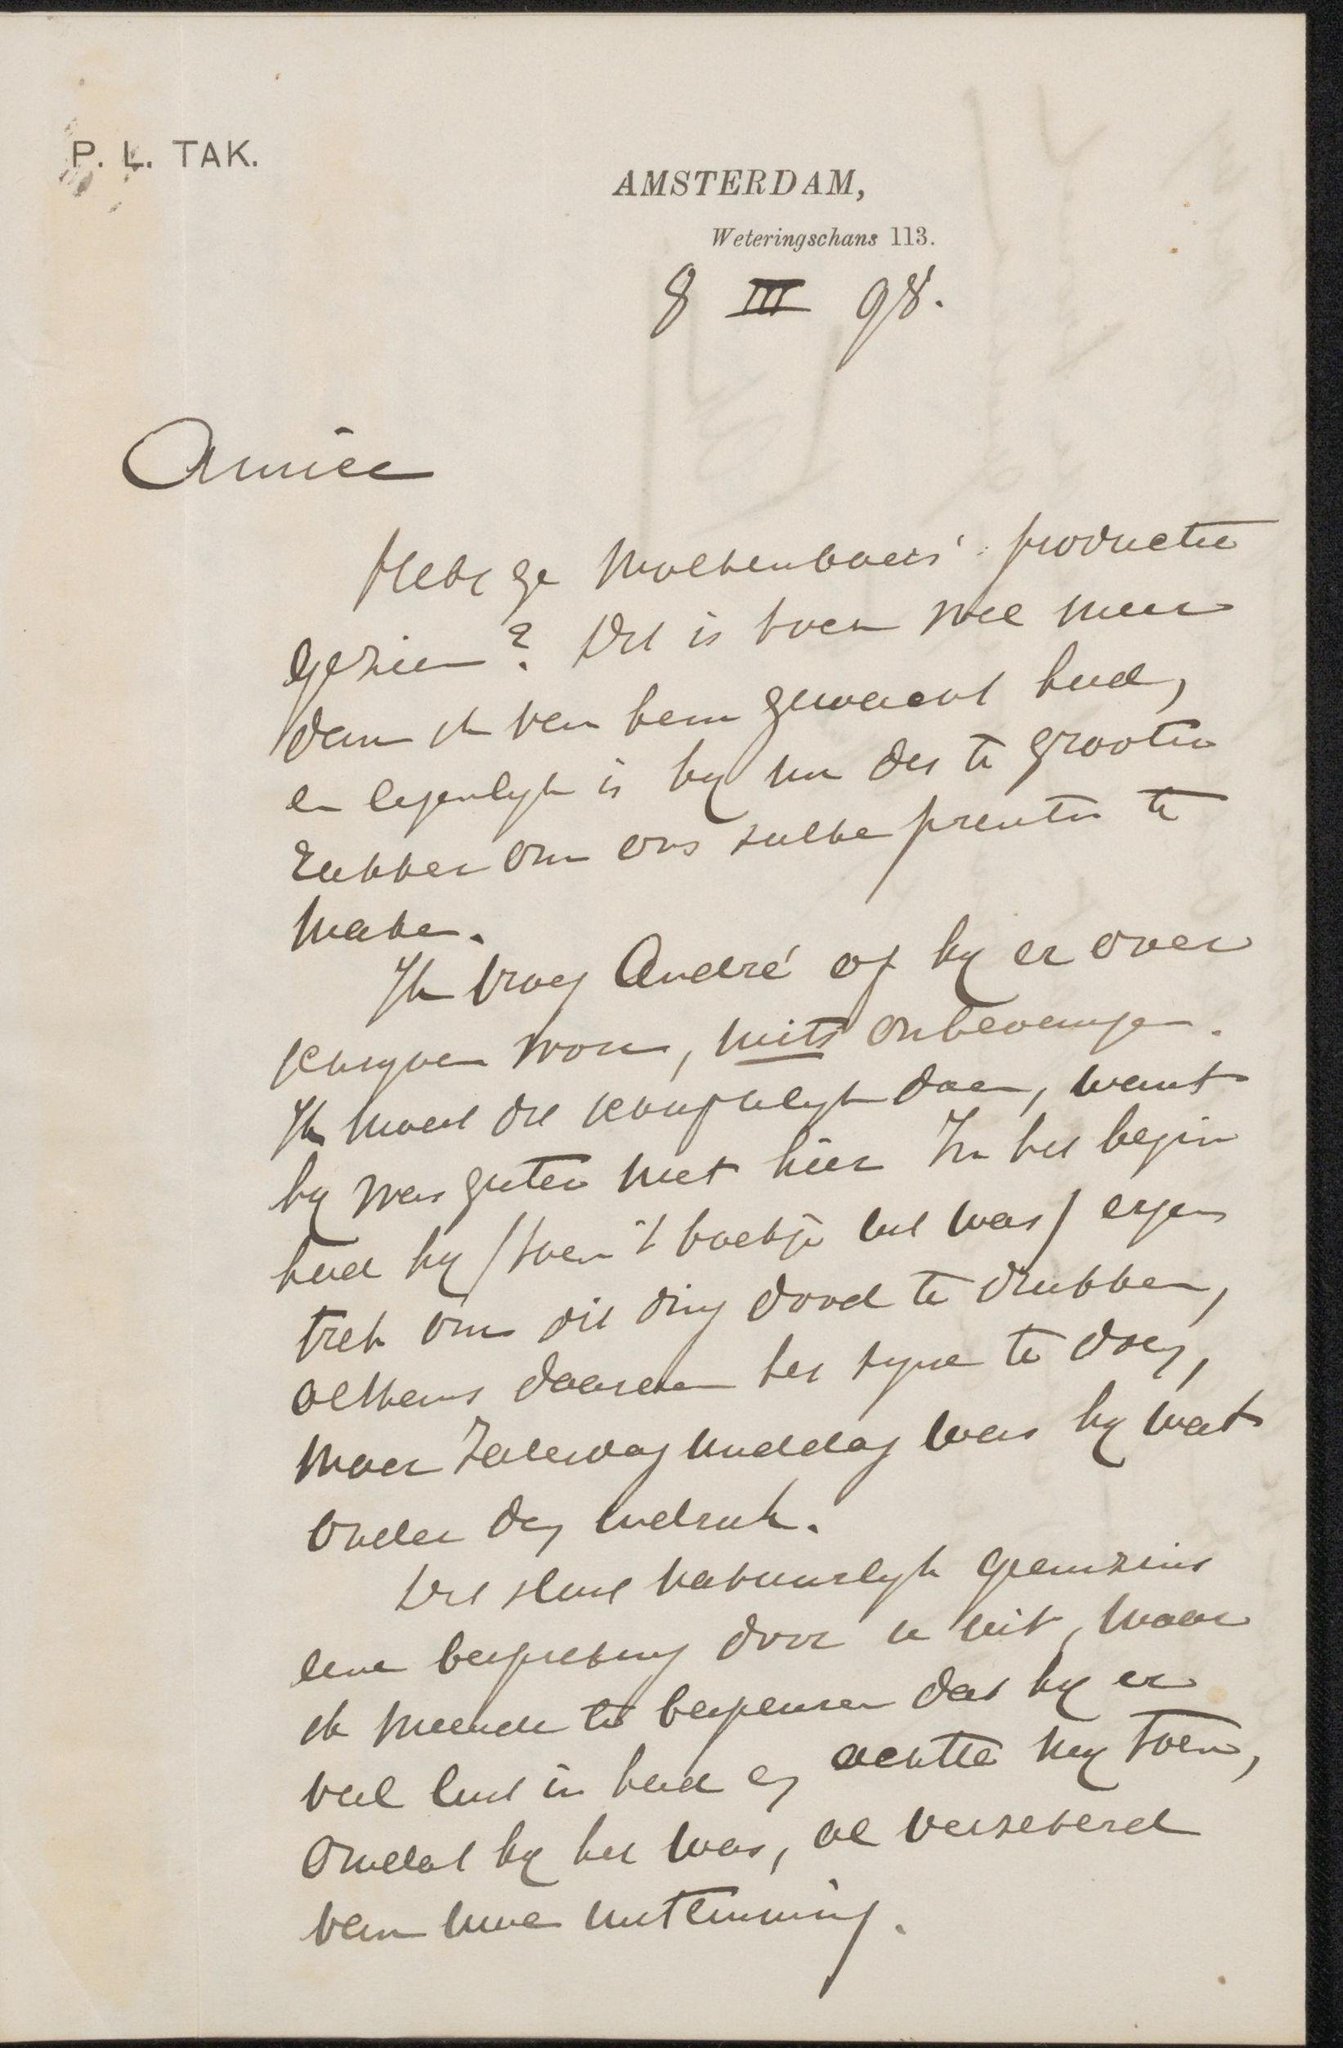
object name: letter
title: Brief aan Jan Veth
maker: pieter lodewijk tak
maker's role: politician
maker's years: 1848-1907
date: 1898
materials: ink, paper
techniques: pen, printing, writing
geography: amsterdam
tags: dordrecht, painter, jan veth, haarlem, anton molkenboer, rotterdam, print maker, draughtsman, simon moulijn, nijmegen, adriaan pit, sculptor, joseph theodorus johannes cuypers, klaas groesbeek, jan kalff, andré jolles, the graphic arts, printed matter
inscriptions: collector's mark: ‘RPK’, watermark